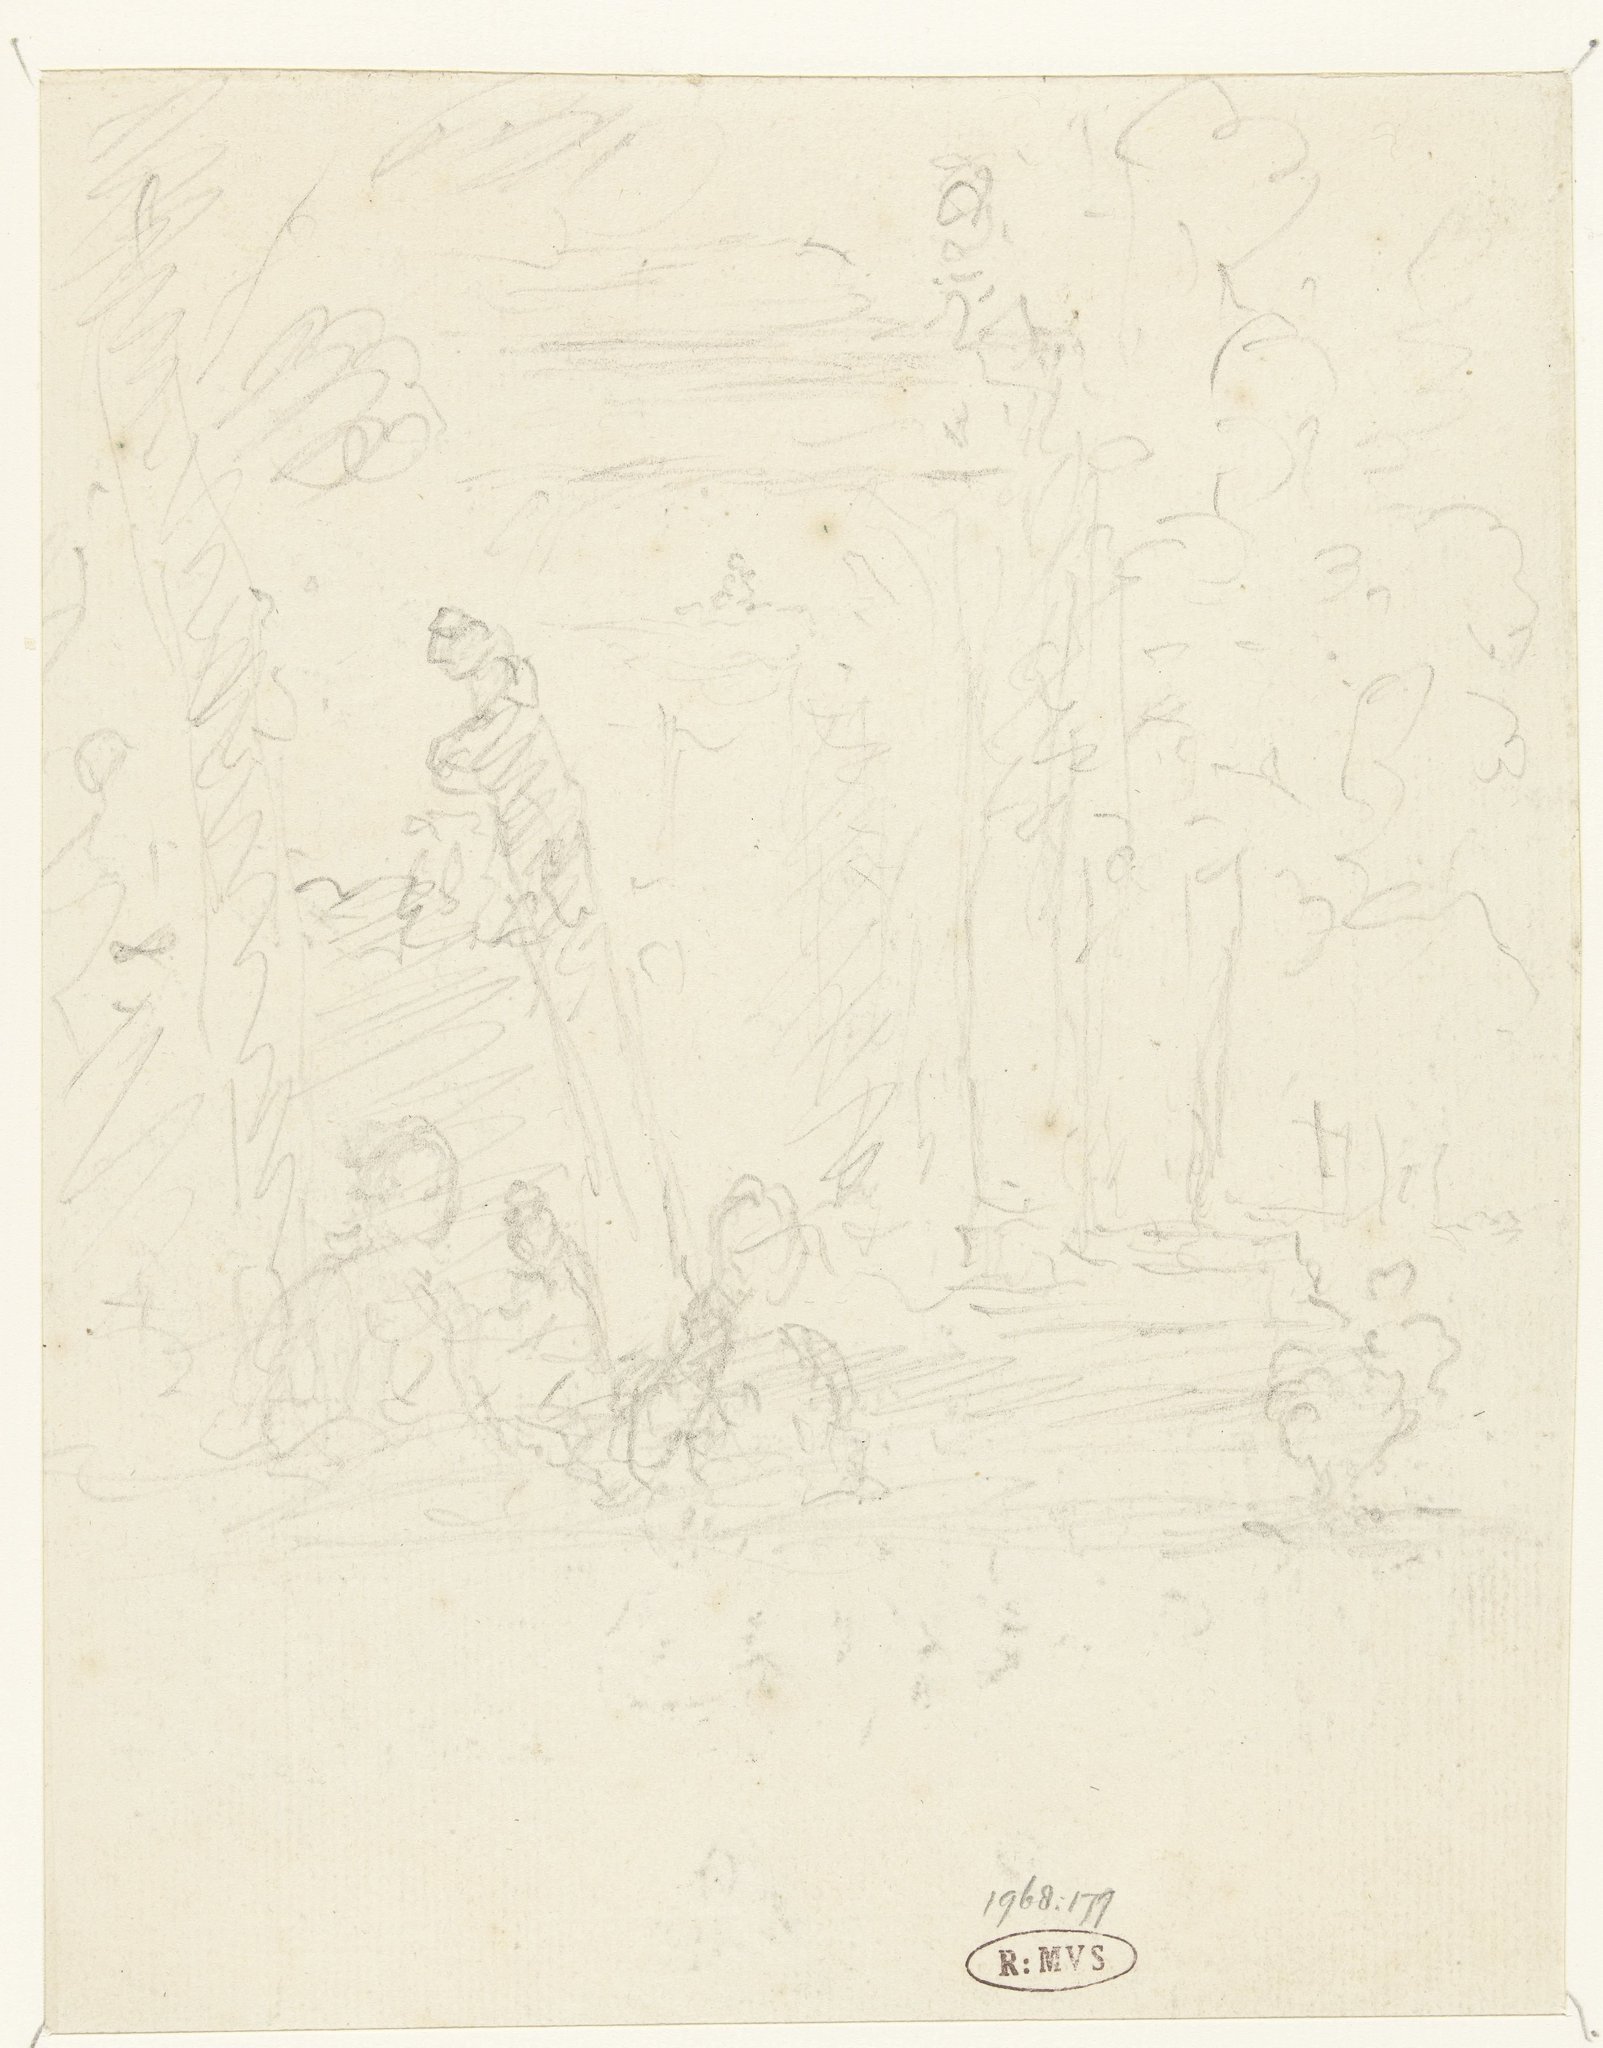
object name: drawing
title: Personen op het terras bij een tuin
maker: dionys van nijmegen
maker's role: draughtsman, painter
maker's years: 1705-1798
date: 1715-1798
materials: paper, pencil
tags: garden